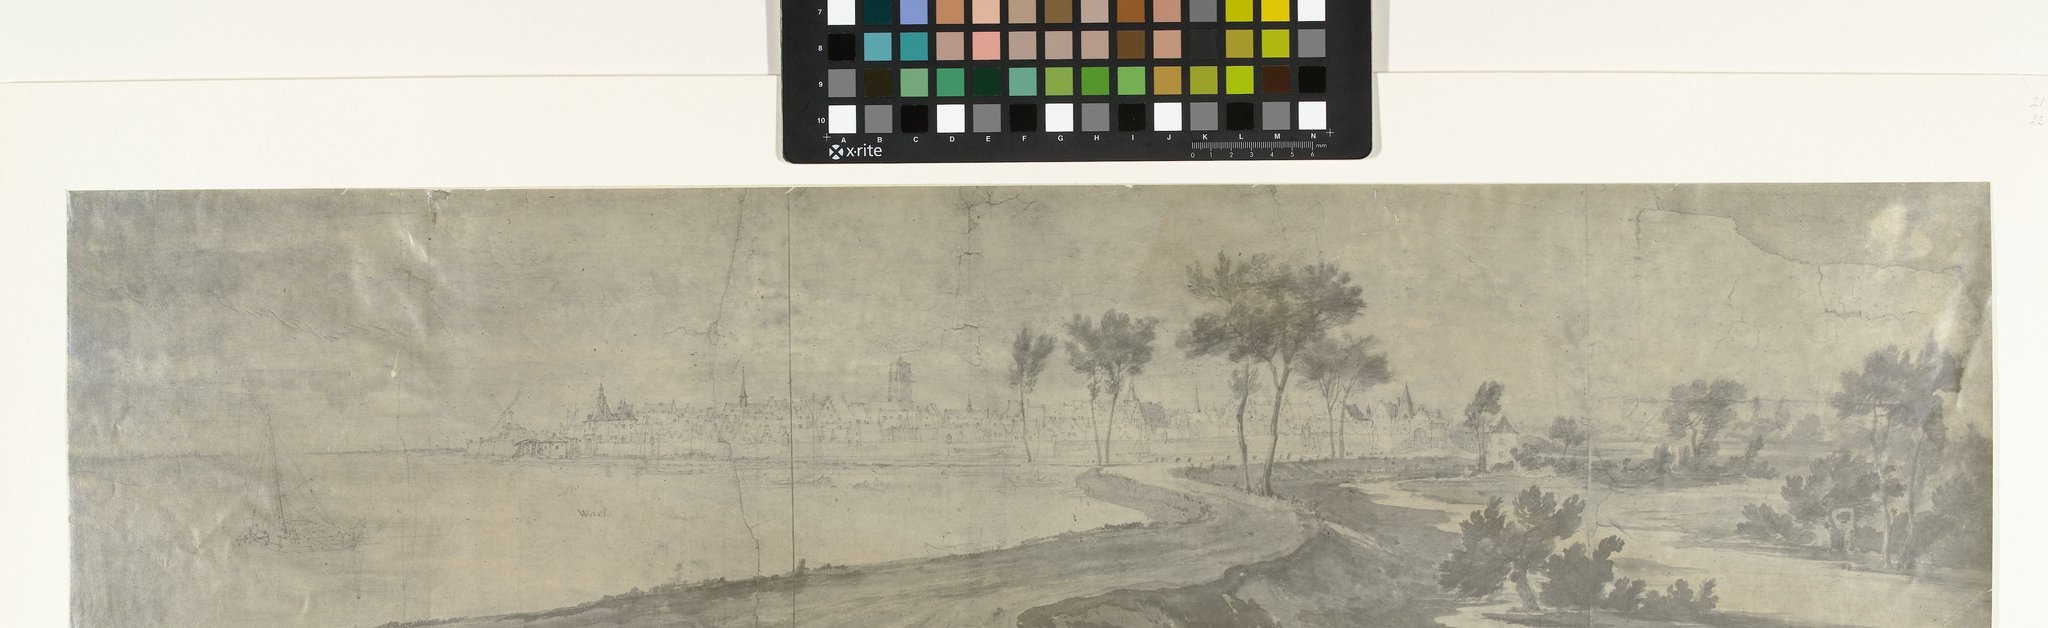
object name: photograph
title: Foto's van tekeningen van de Franse inval in de Nederlanden in 1672 door Adam Frans van der Meulen bewaard in de Manufacture des Gobelins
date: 1900-1903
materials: paper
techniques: gelatin silver print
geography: france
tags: lodewijk xiv (koning van frankrijk), city-view, and landscape with man-made constructions, rampjaar (disaster year)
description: Niet in Frederik Muller; door het RPK toegevoegd nummer. Onderdeel van een groep van ca. 50 foto's van tekeningen van de Franse inval in de Nederlanden in 1672 door Adam Frans van der Meulen, bewaard in de Manufacture Nationale des Gobelins te Parijs.